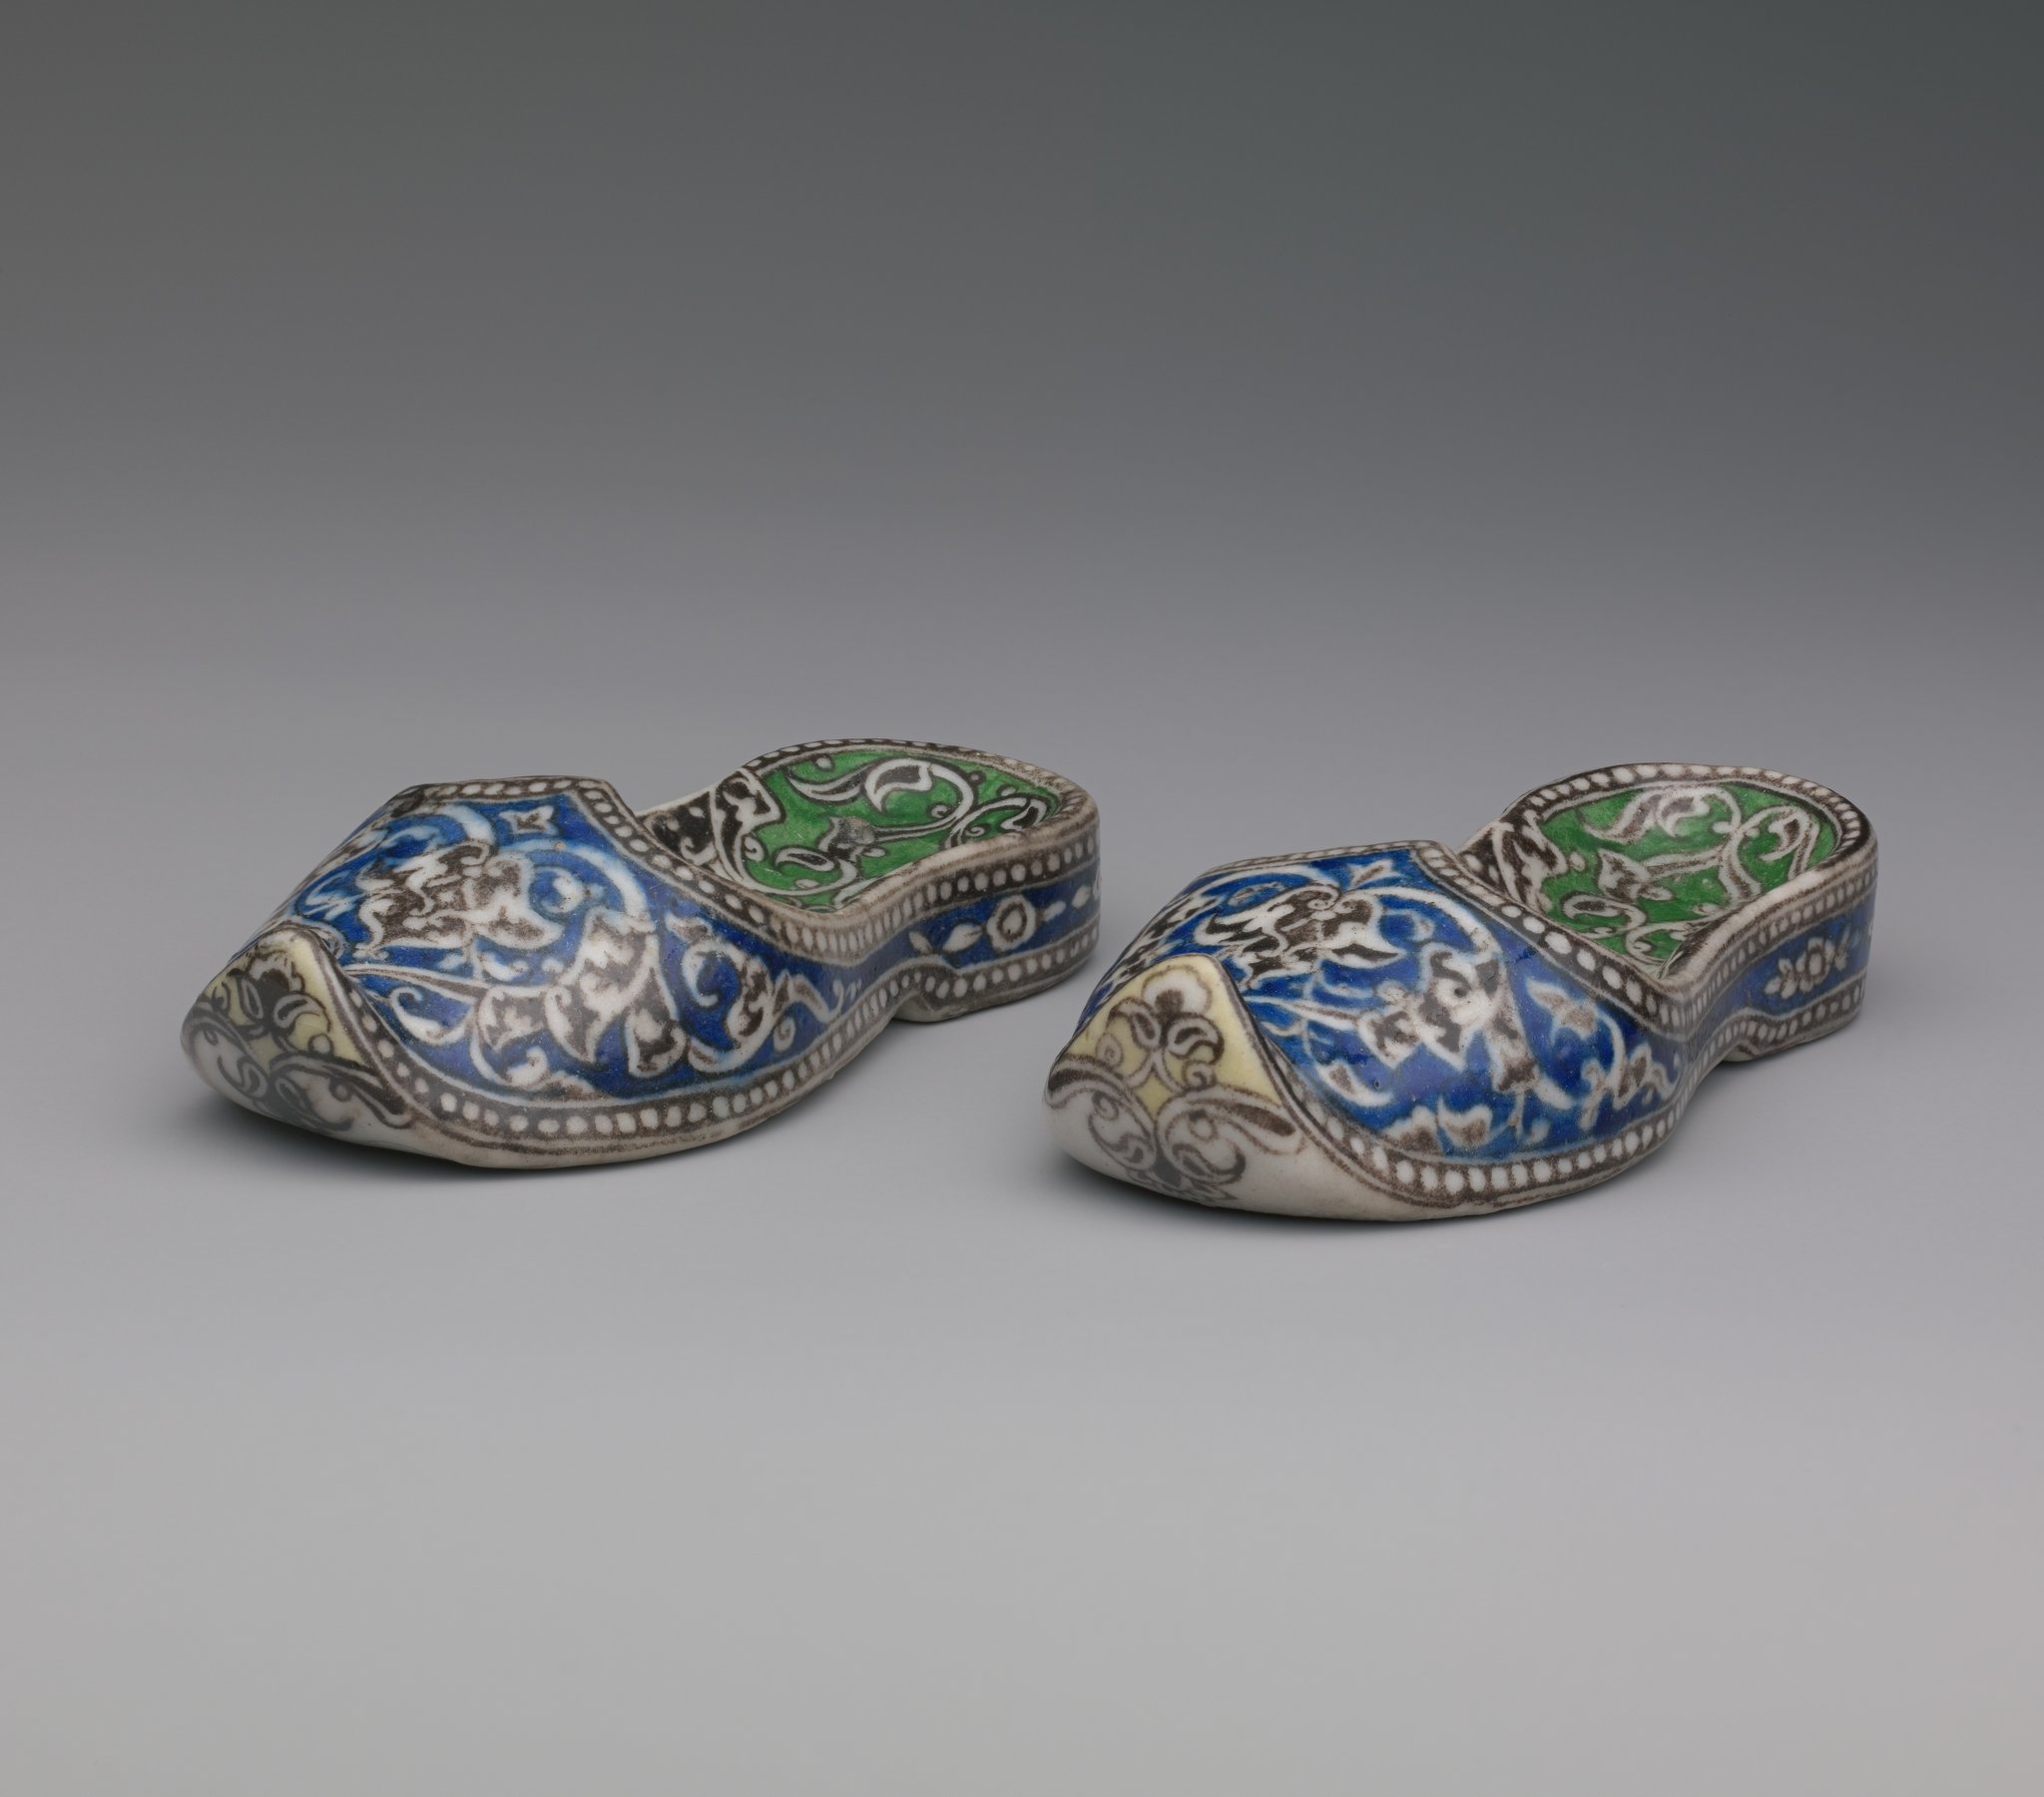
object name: slipper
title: Pair of Qajar Ceramic Slippers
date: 1880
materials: glaze, stonepaste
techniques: painting, underglaze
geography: iran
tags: shoes